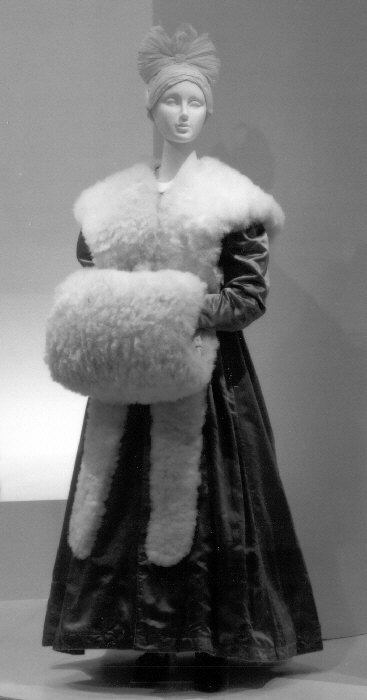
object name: accessory set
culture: british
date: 1825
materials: feather, silk